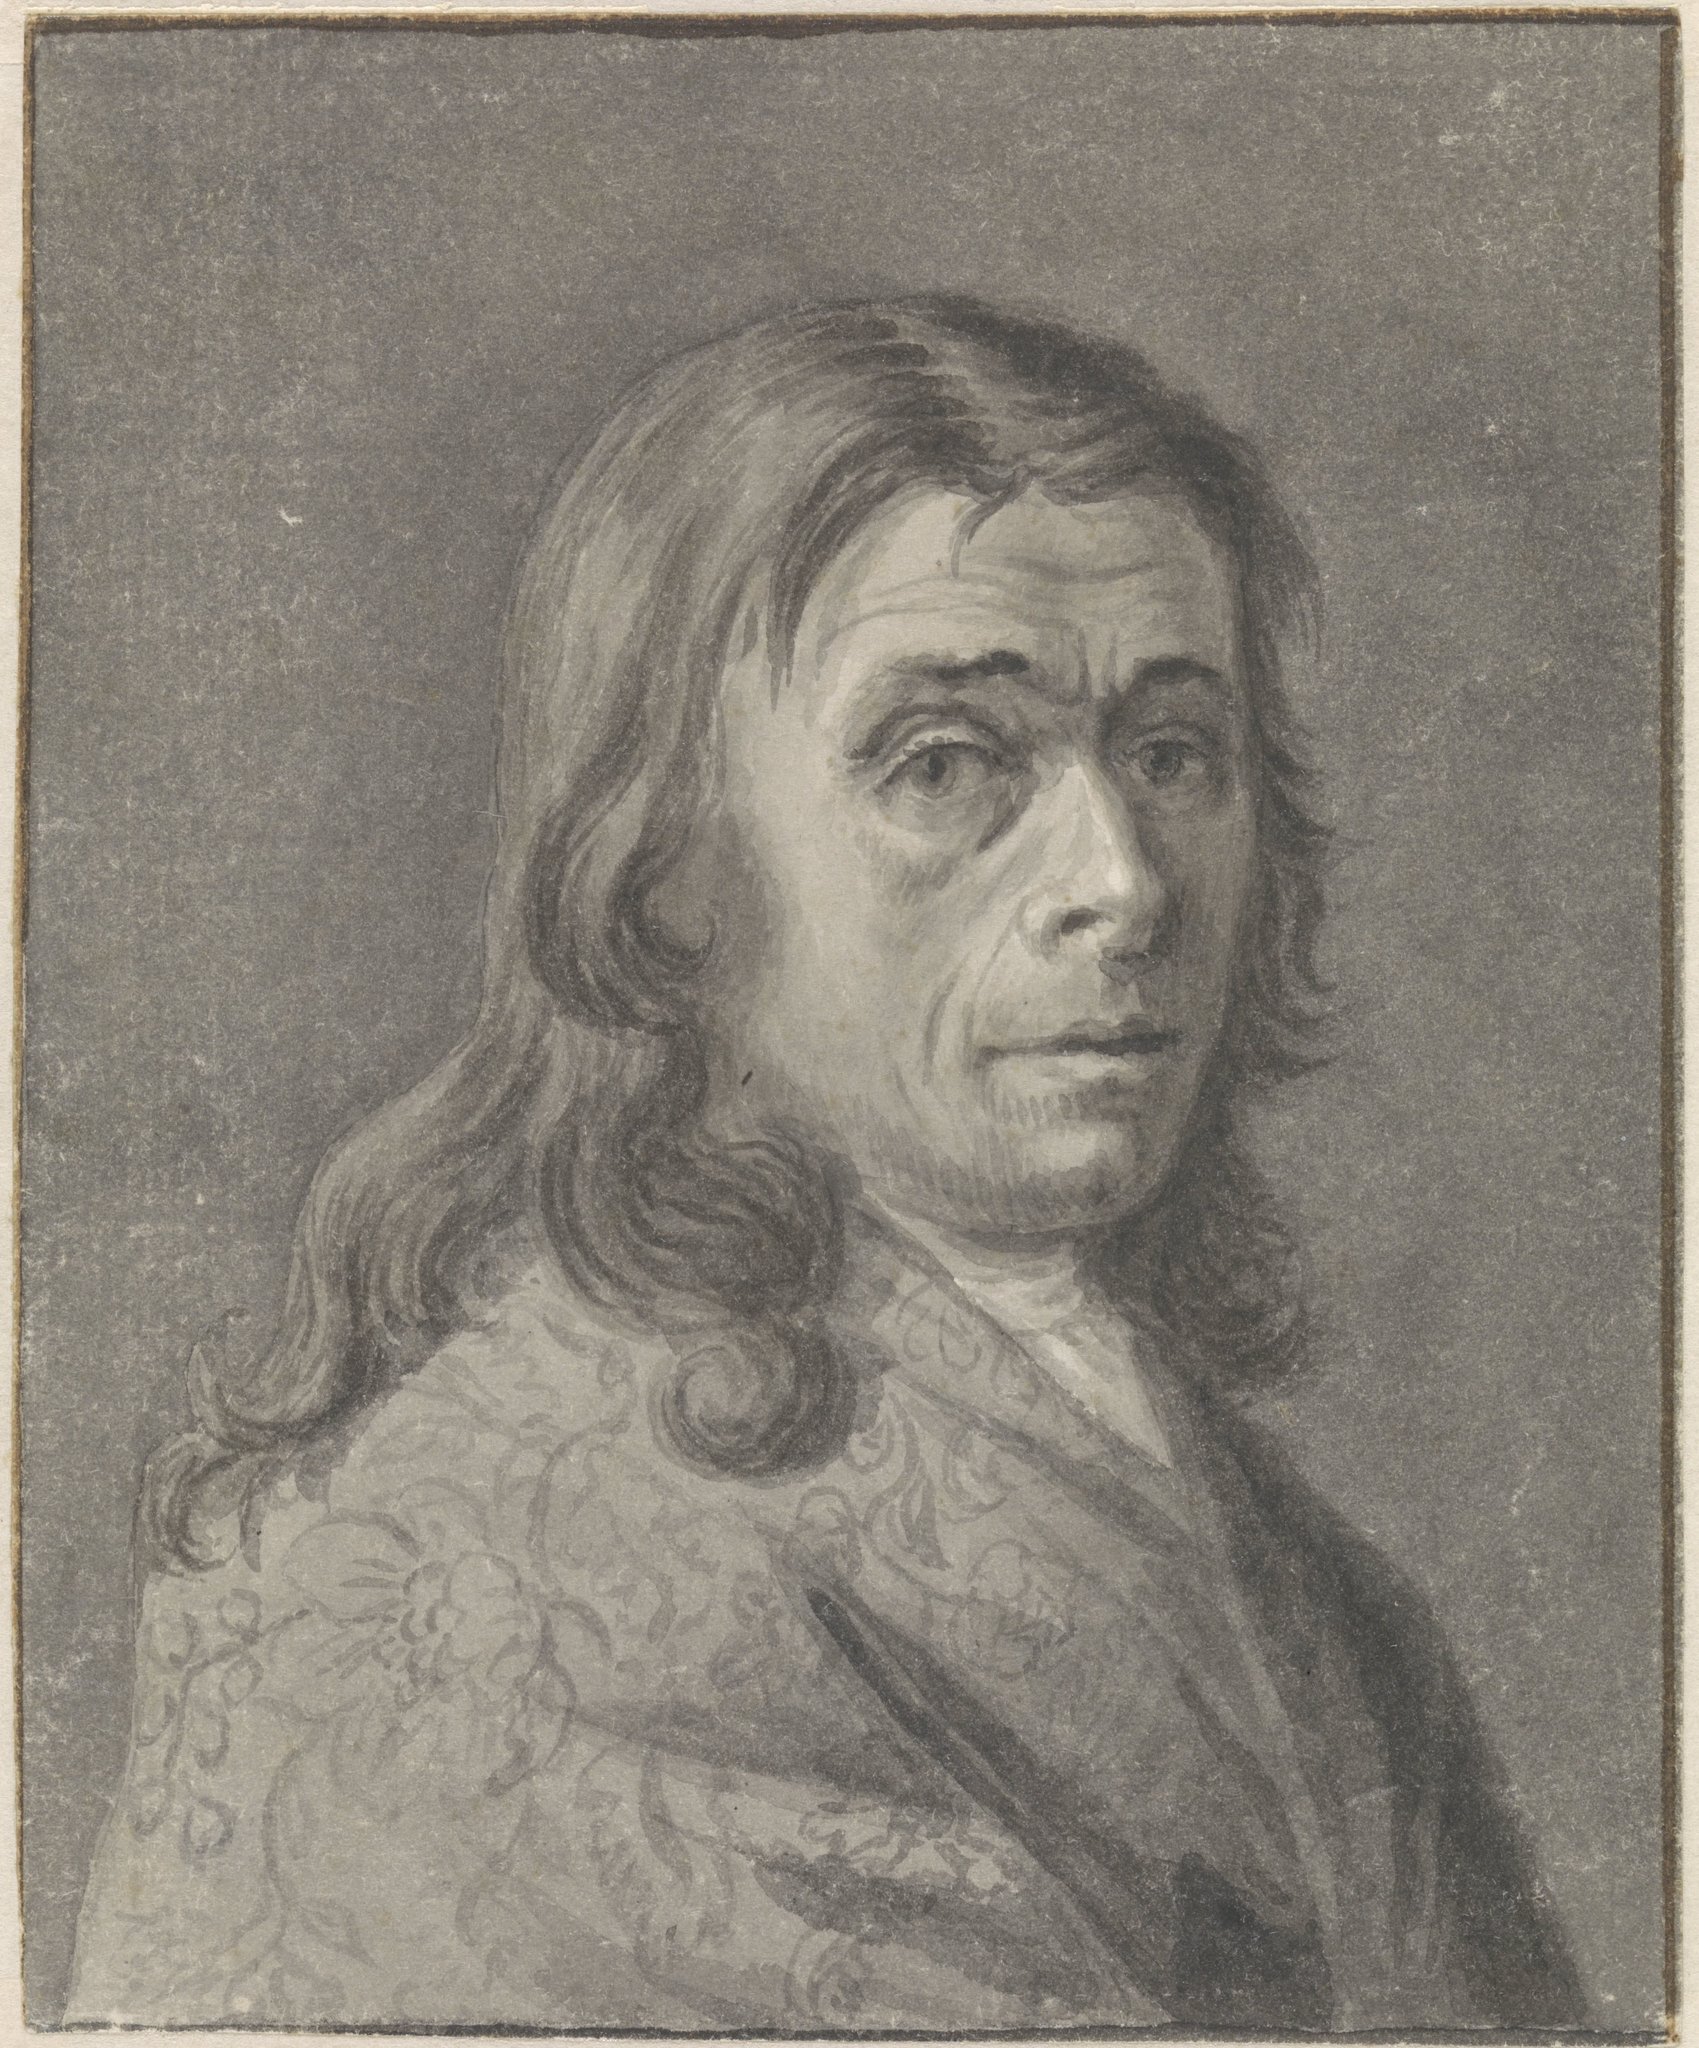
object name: drawing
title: Zelfportret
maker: cornelis van den berg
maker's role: draughtsman, print maker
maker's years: 1699-1774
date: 1750-1774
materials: paper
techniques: brush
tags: haarlem, print maker, cornelis van den berg, historical persons, portrait, self-portrait of painter, portrait, self-portrait of artist, portrait, self-portrait of draughtsman